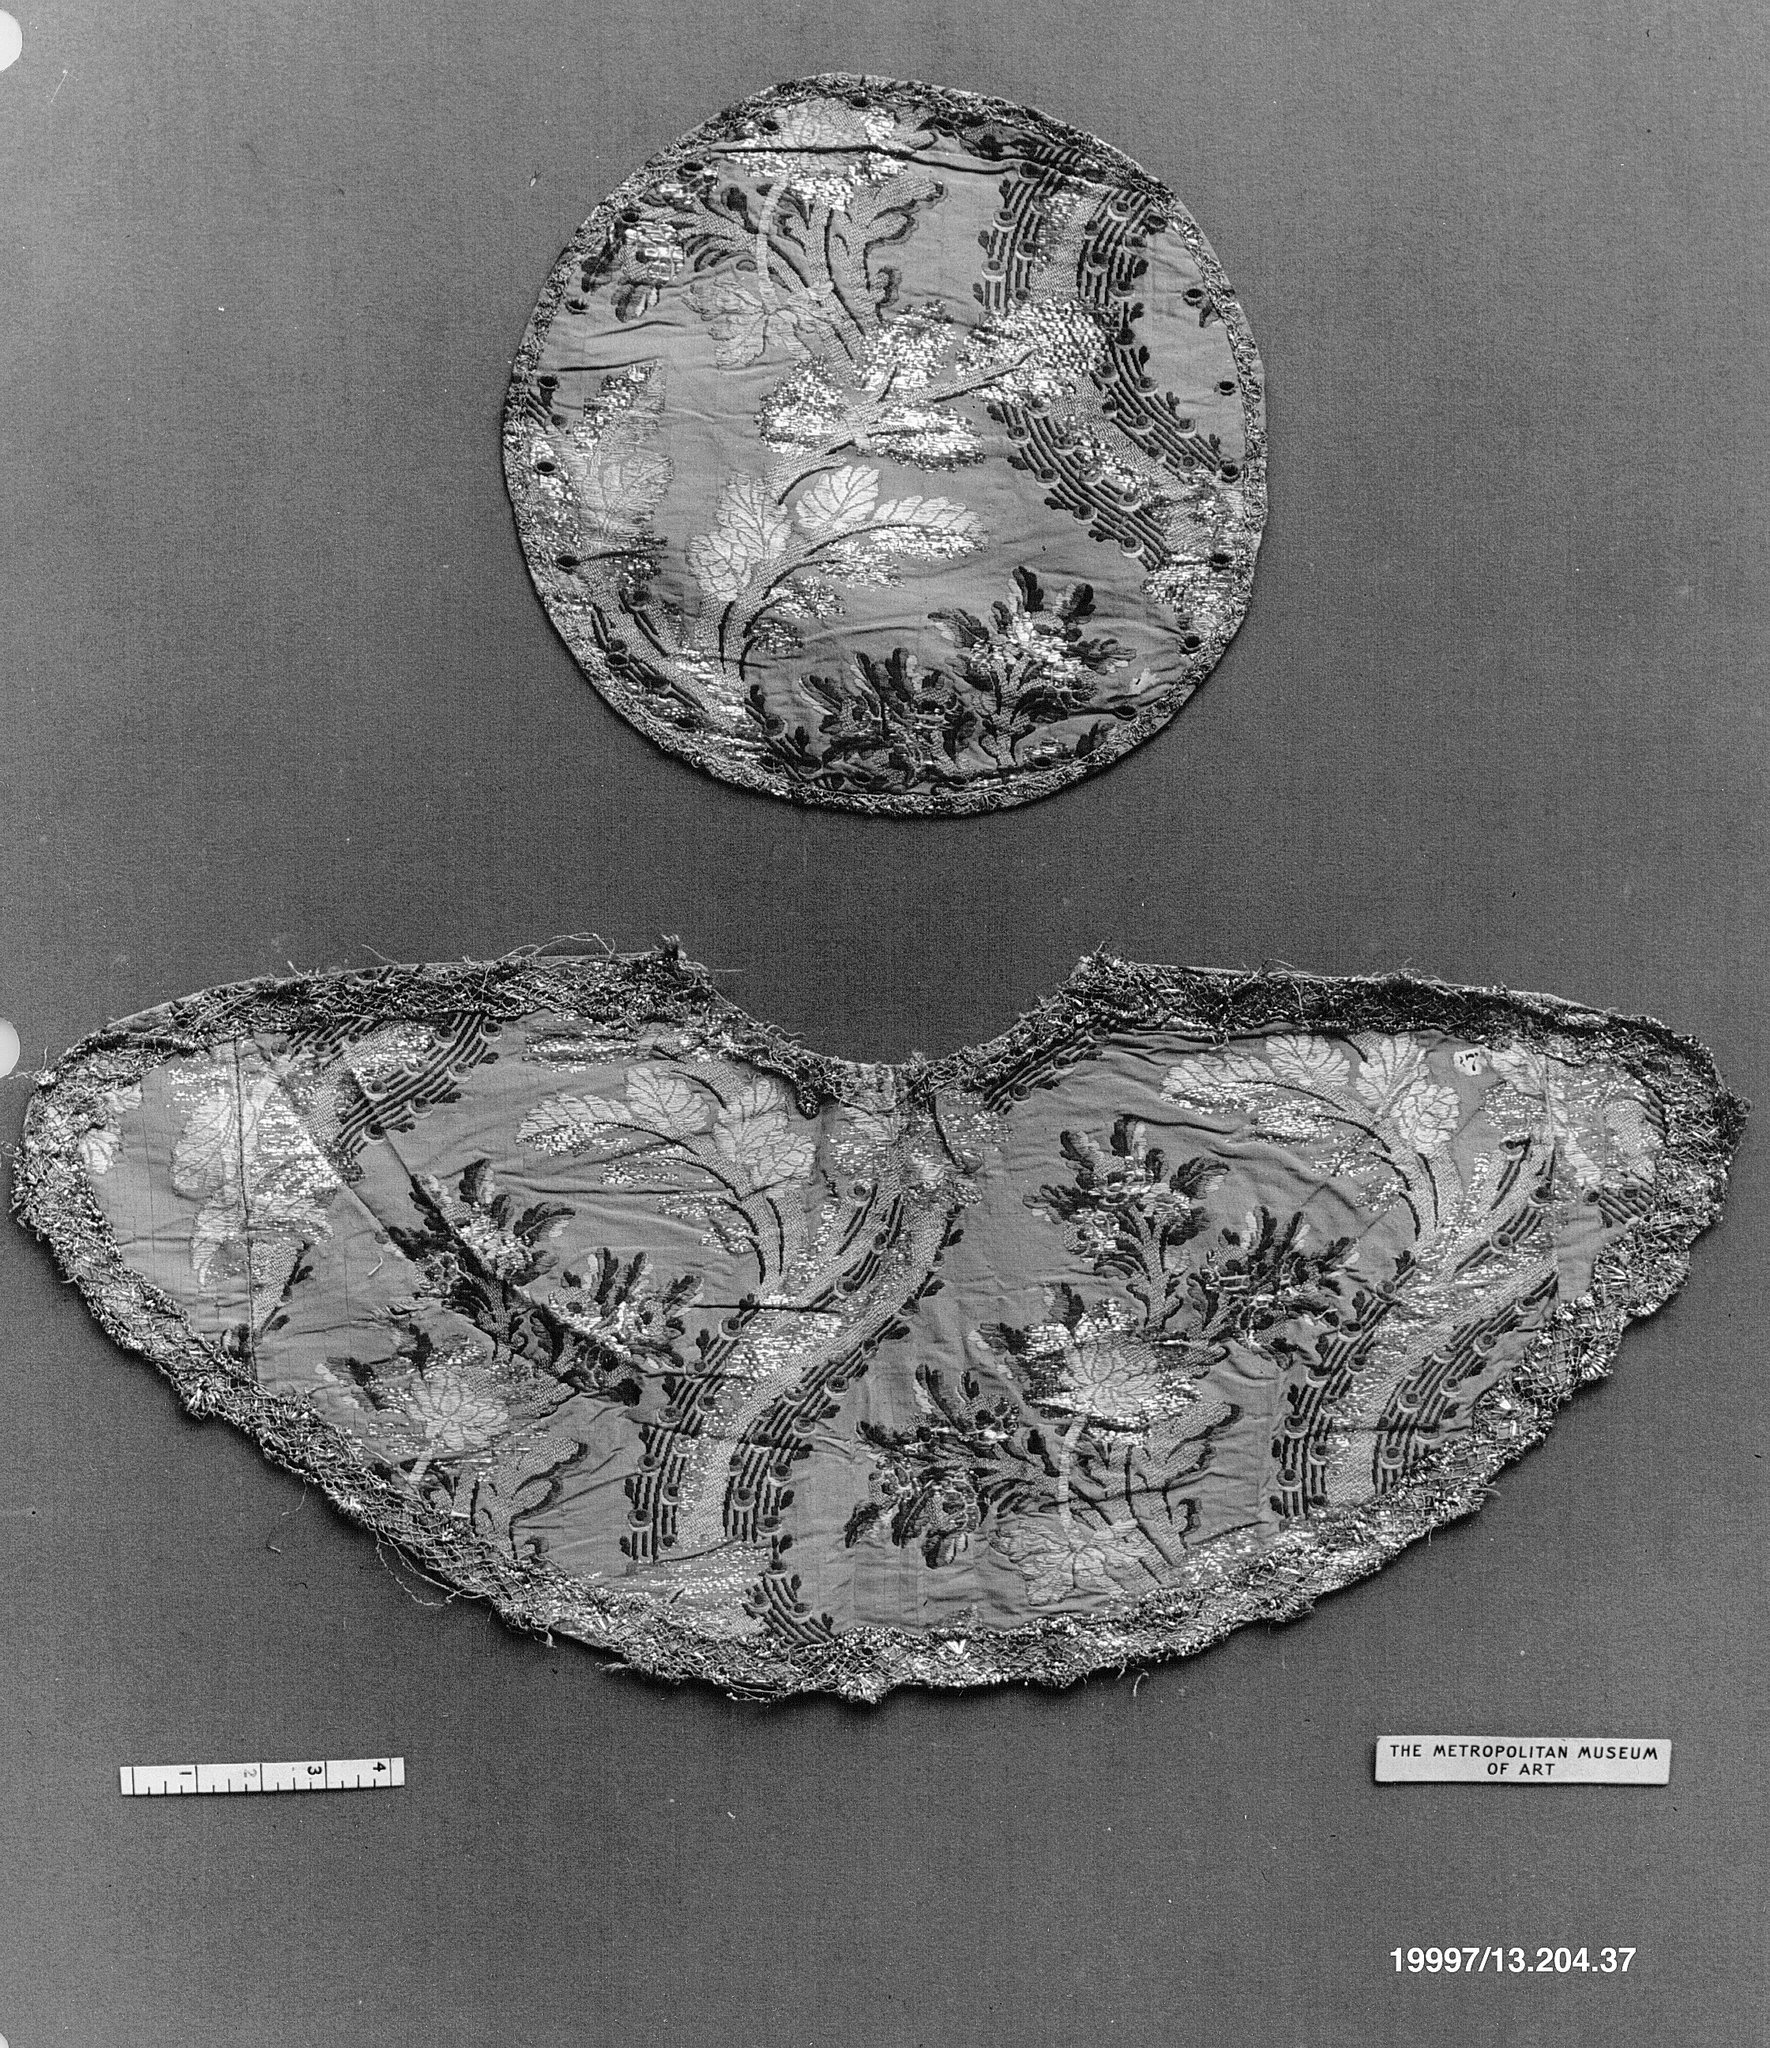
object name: piece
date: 1750-1760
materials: metal thread, silk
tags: flowers,leaves